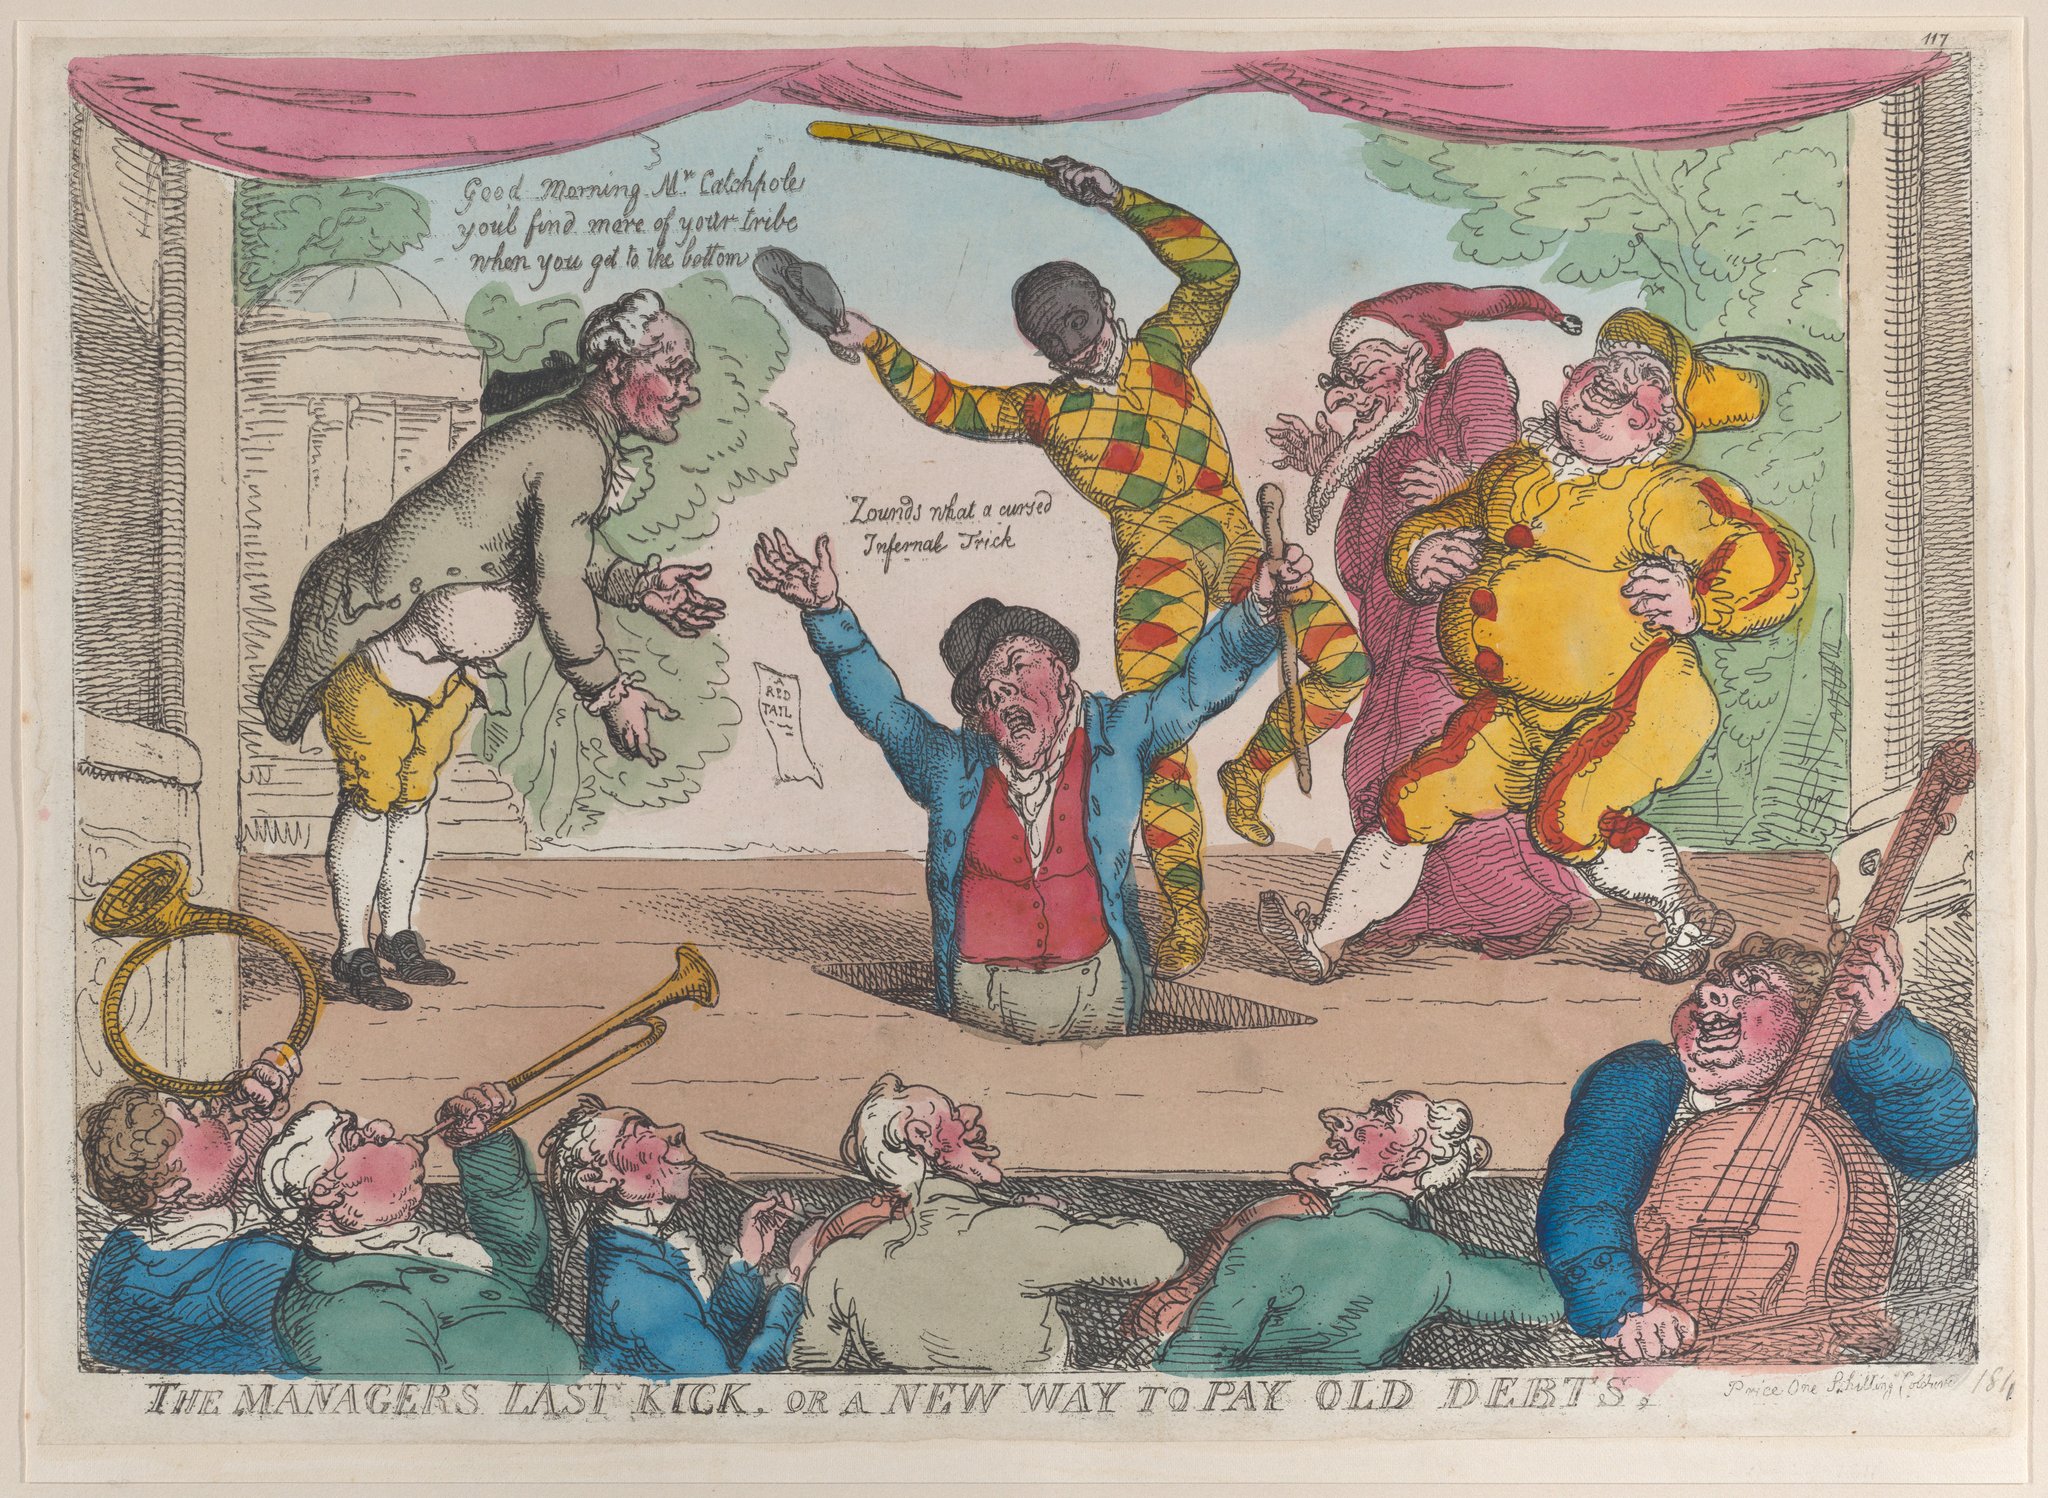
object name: print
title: The Manager's Last Kick, or a New Way to Pay Old Debts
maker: thomas rowlandson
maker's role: artist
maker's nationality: british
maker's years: 1757-1827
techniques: etching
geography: london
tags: performance,satire,theatre,men,musicians